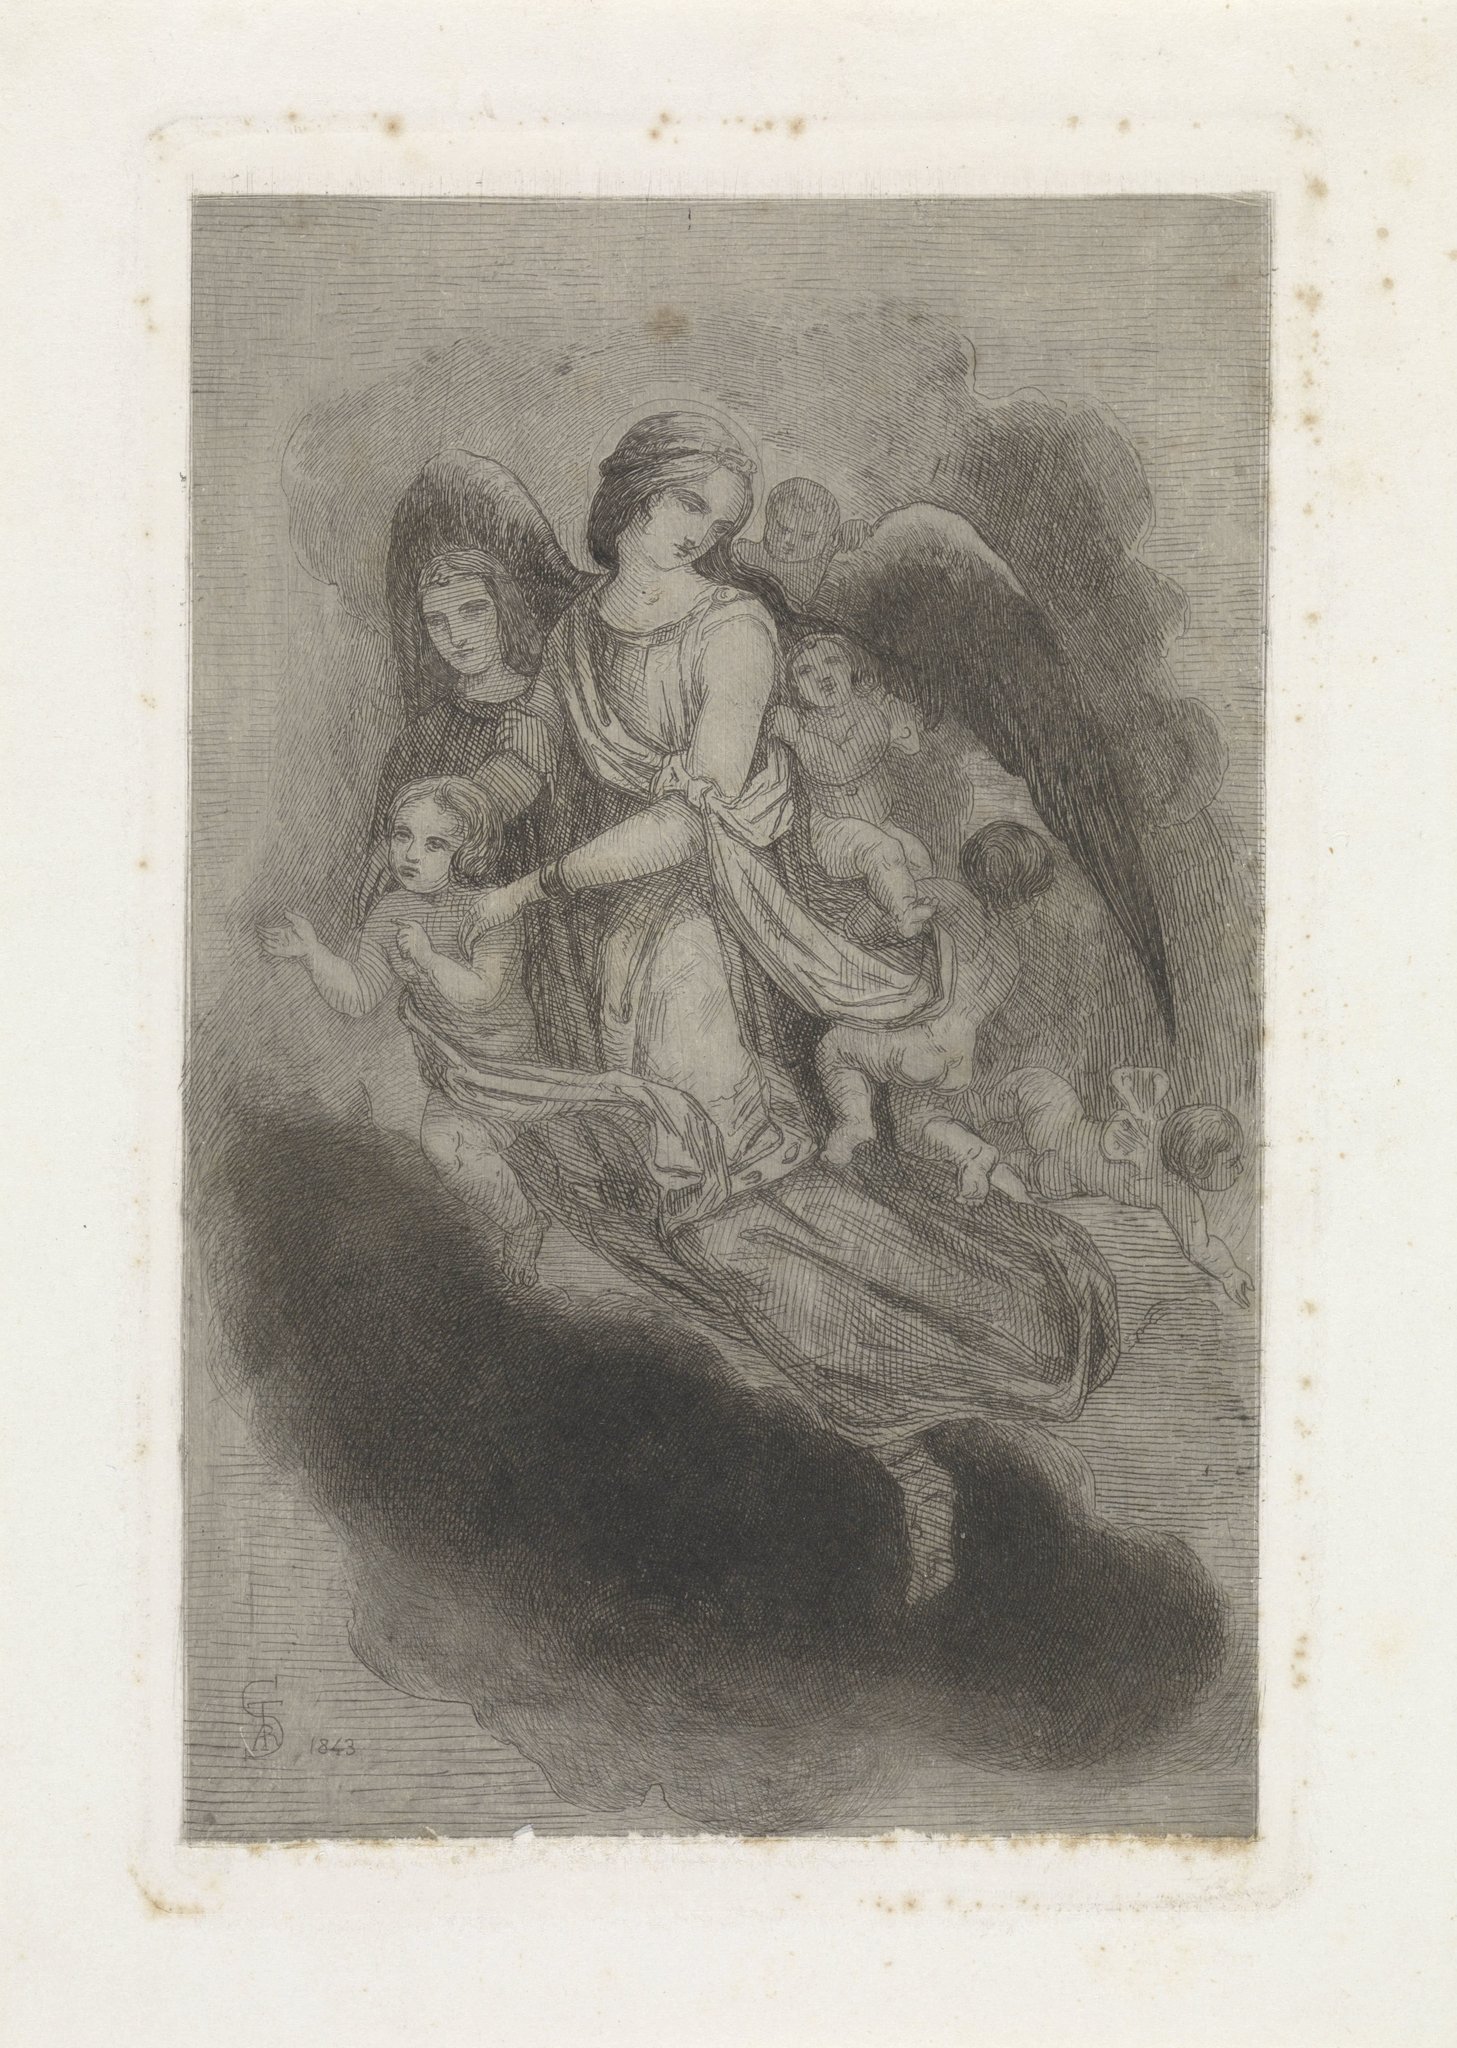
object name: print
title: Liefde (Caritas)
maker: arnoud schaepkens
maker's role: print maker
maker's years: 1816-1904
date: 1843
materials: paper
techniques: drypoint, etching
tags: charity, 'caritas'; 'carità' (ripa) ~ one of the three theological virtues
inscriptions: collector's mark: Lugt 1485, collector's mark: Lugt 2228